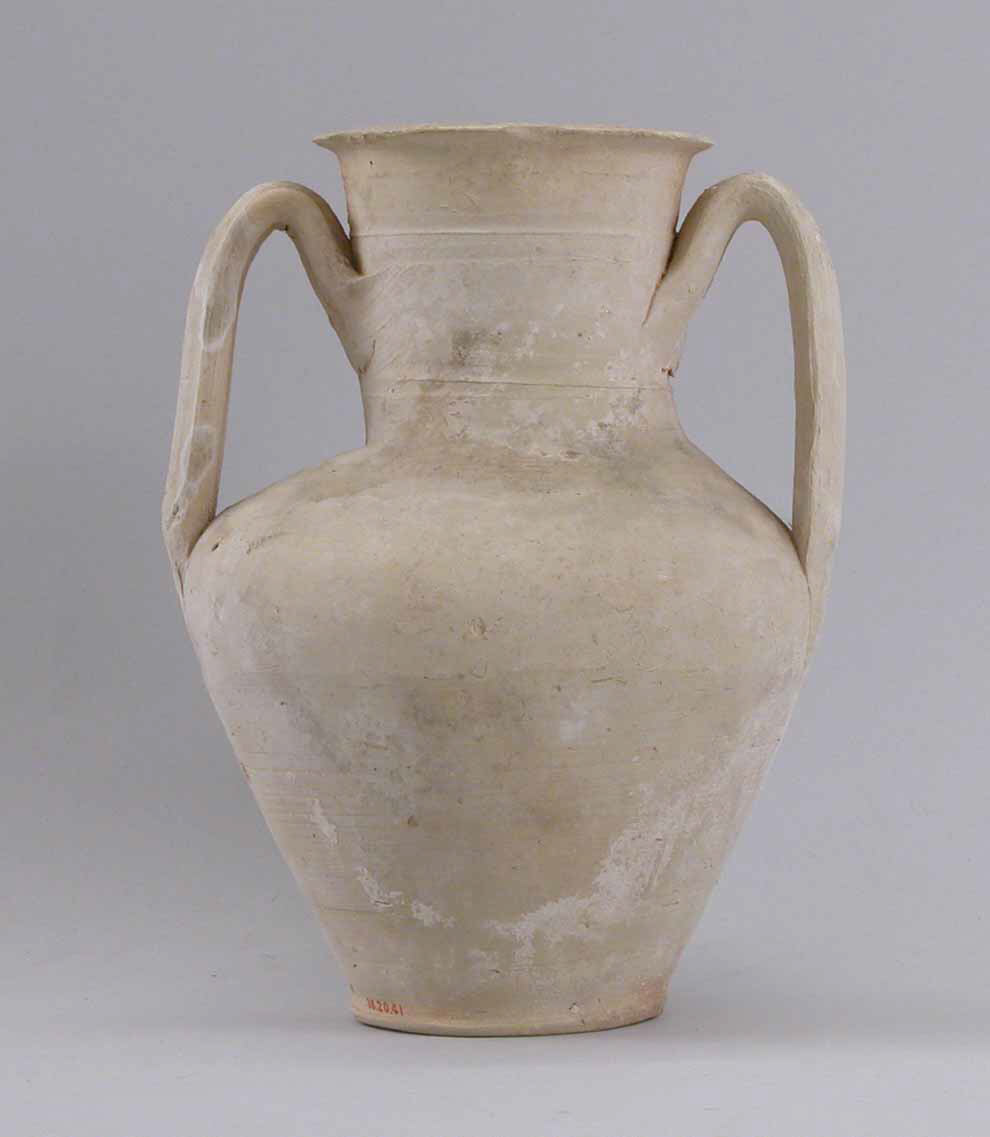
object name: jar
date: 801-1000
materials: earthenware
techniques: incising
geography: iran